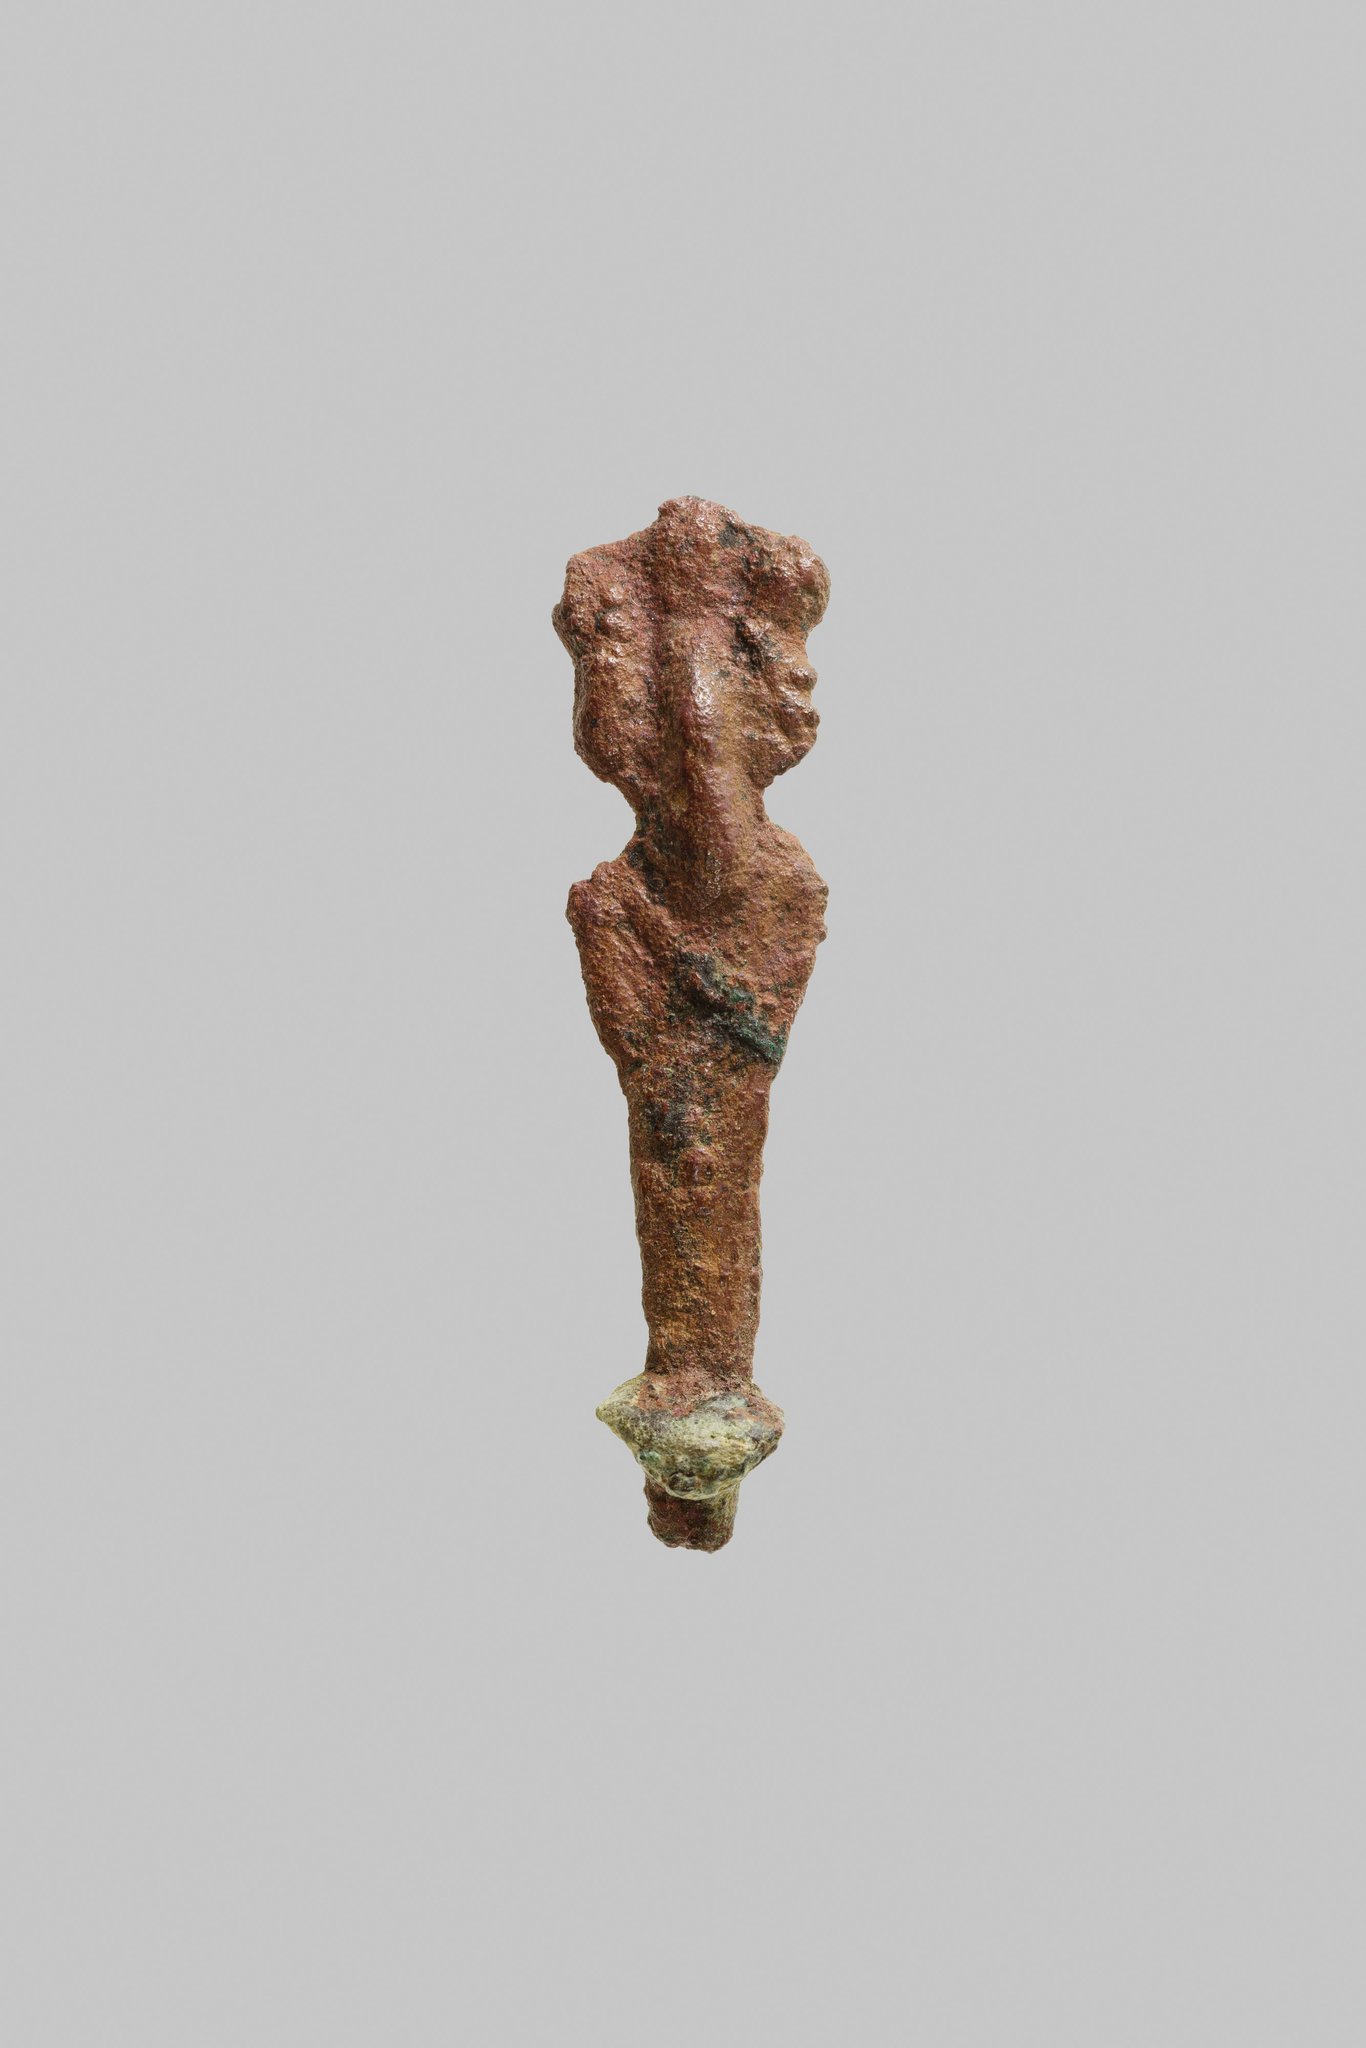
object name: statuette, osiris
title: Osiris Figure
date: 712-30 BCE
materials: bronze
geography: egypt